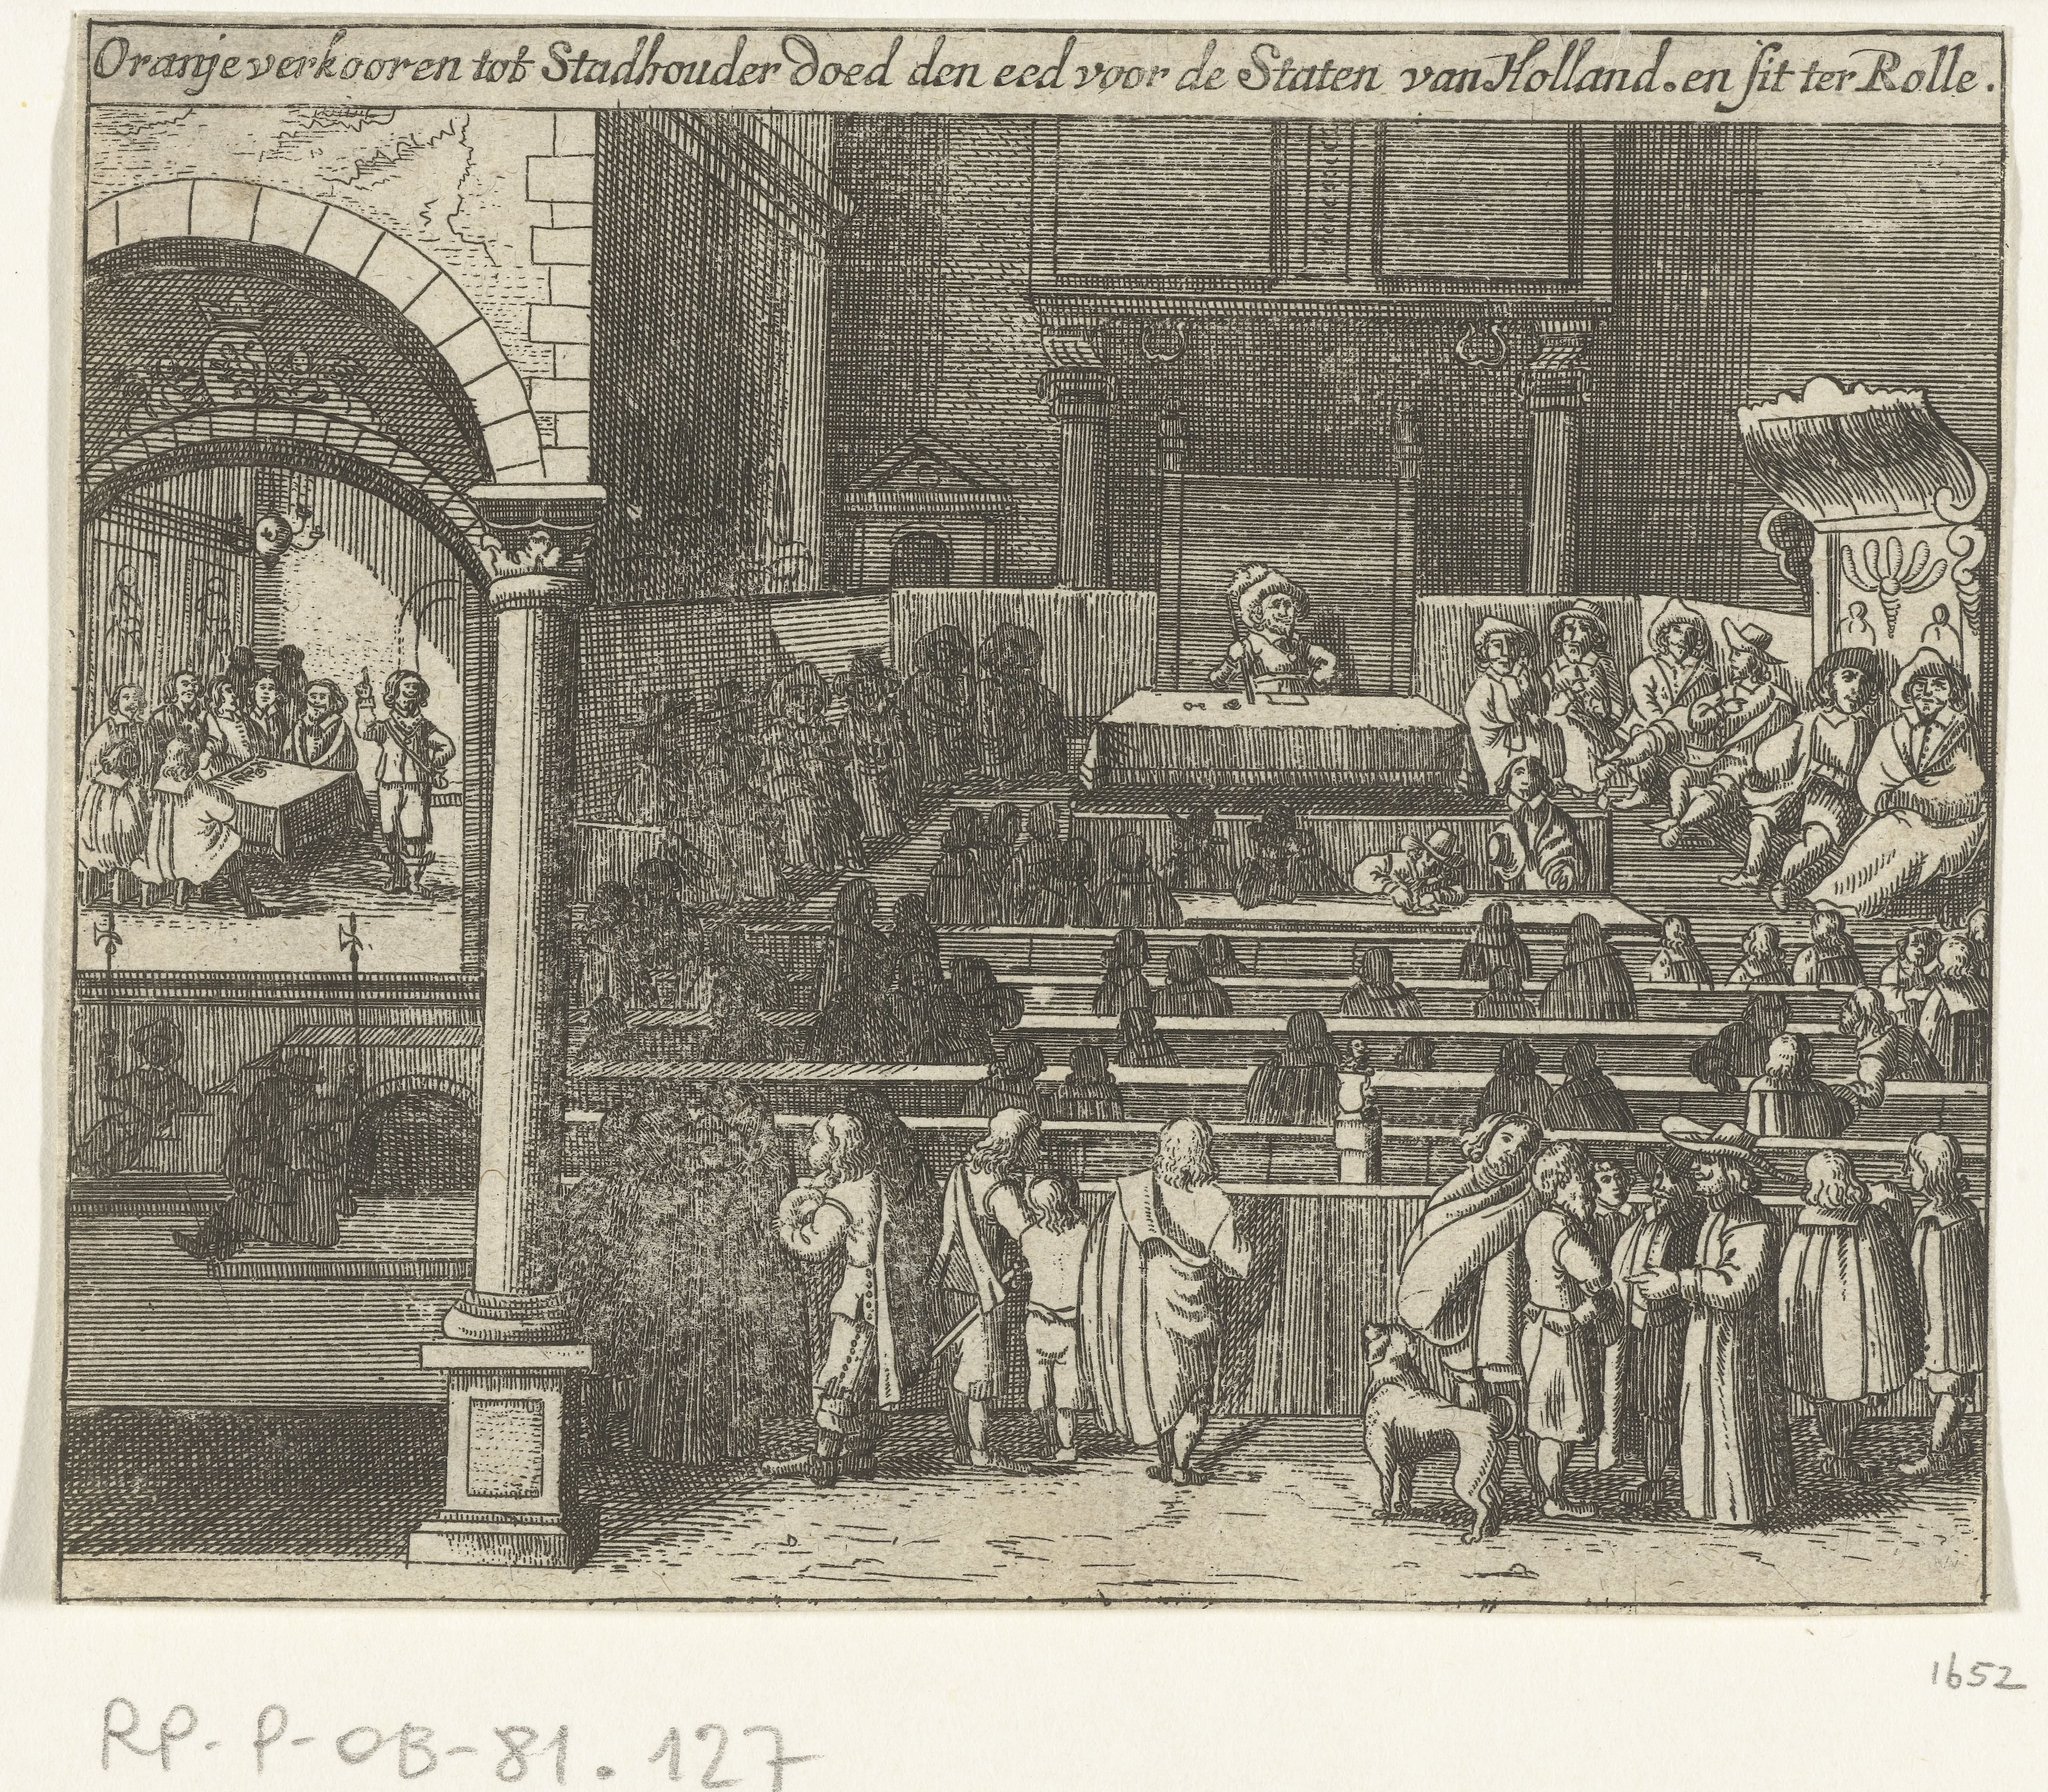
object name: print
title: Frederik Hendrik legt de eed af als stadhouder en neemt zitting in de Staten van Holland, 1625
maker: Anonymous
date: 1650-1652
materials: paper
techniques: etching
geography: northern netherlands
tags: delft, frederick henry (prince of orange), new ruler taking the oath, popular representation ~ government, the hague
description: Gebruikt als illustratie in: A. Montanus, 'T leven en bedryf van Frederik Henrik, J. Hartgers, Amsterdam 1652, p. 117. Kopie naar de prent in: I. Commelin, Frederick Hendrick van Nassauw Prince van Orangien : zyn leven en bedryf, Jodocus Janssonius, Amsterdam 1651, fol. 7 (FMH 1549).